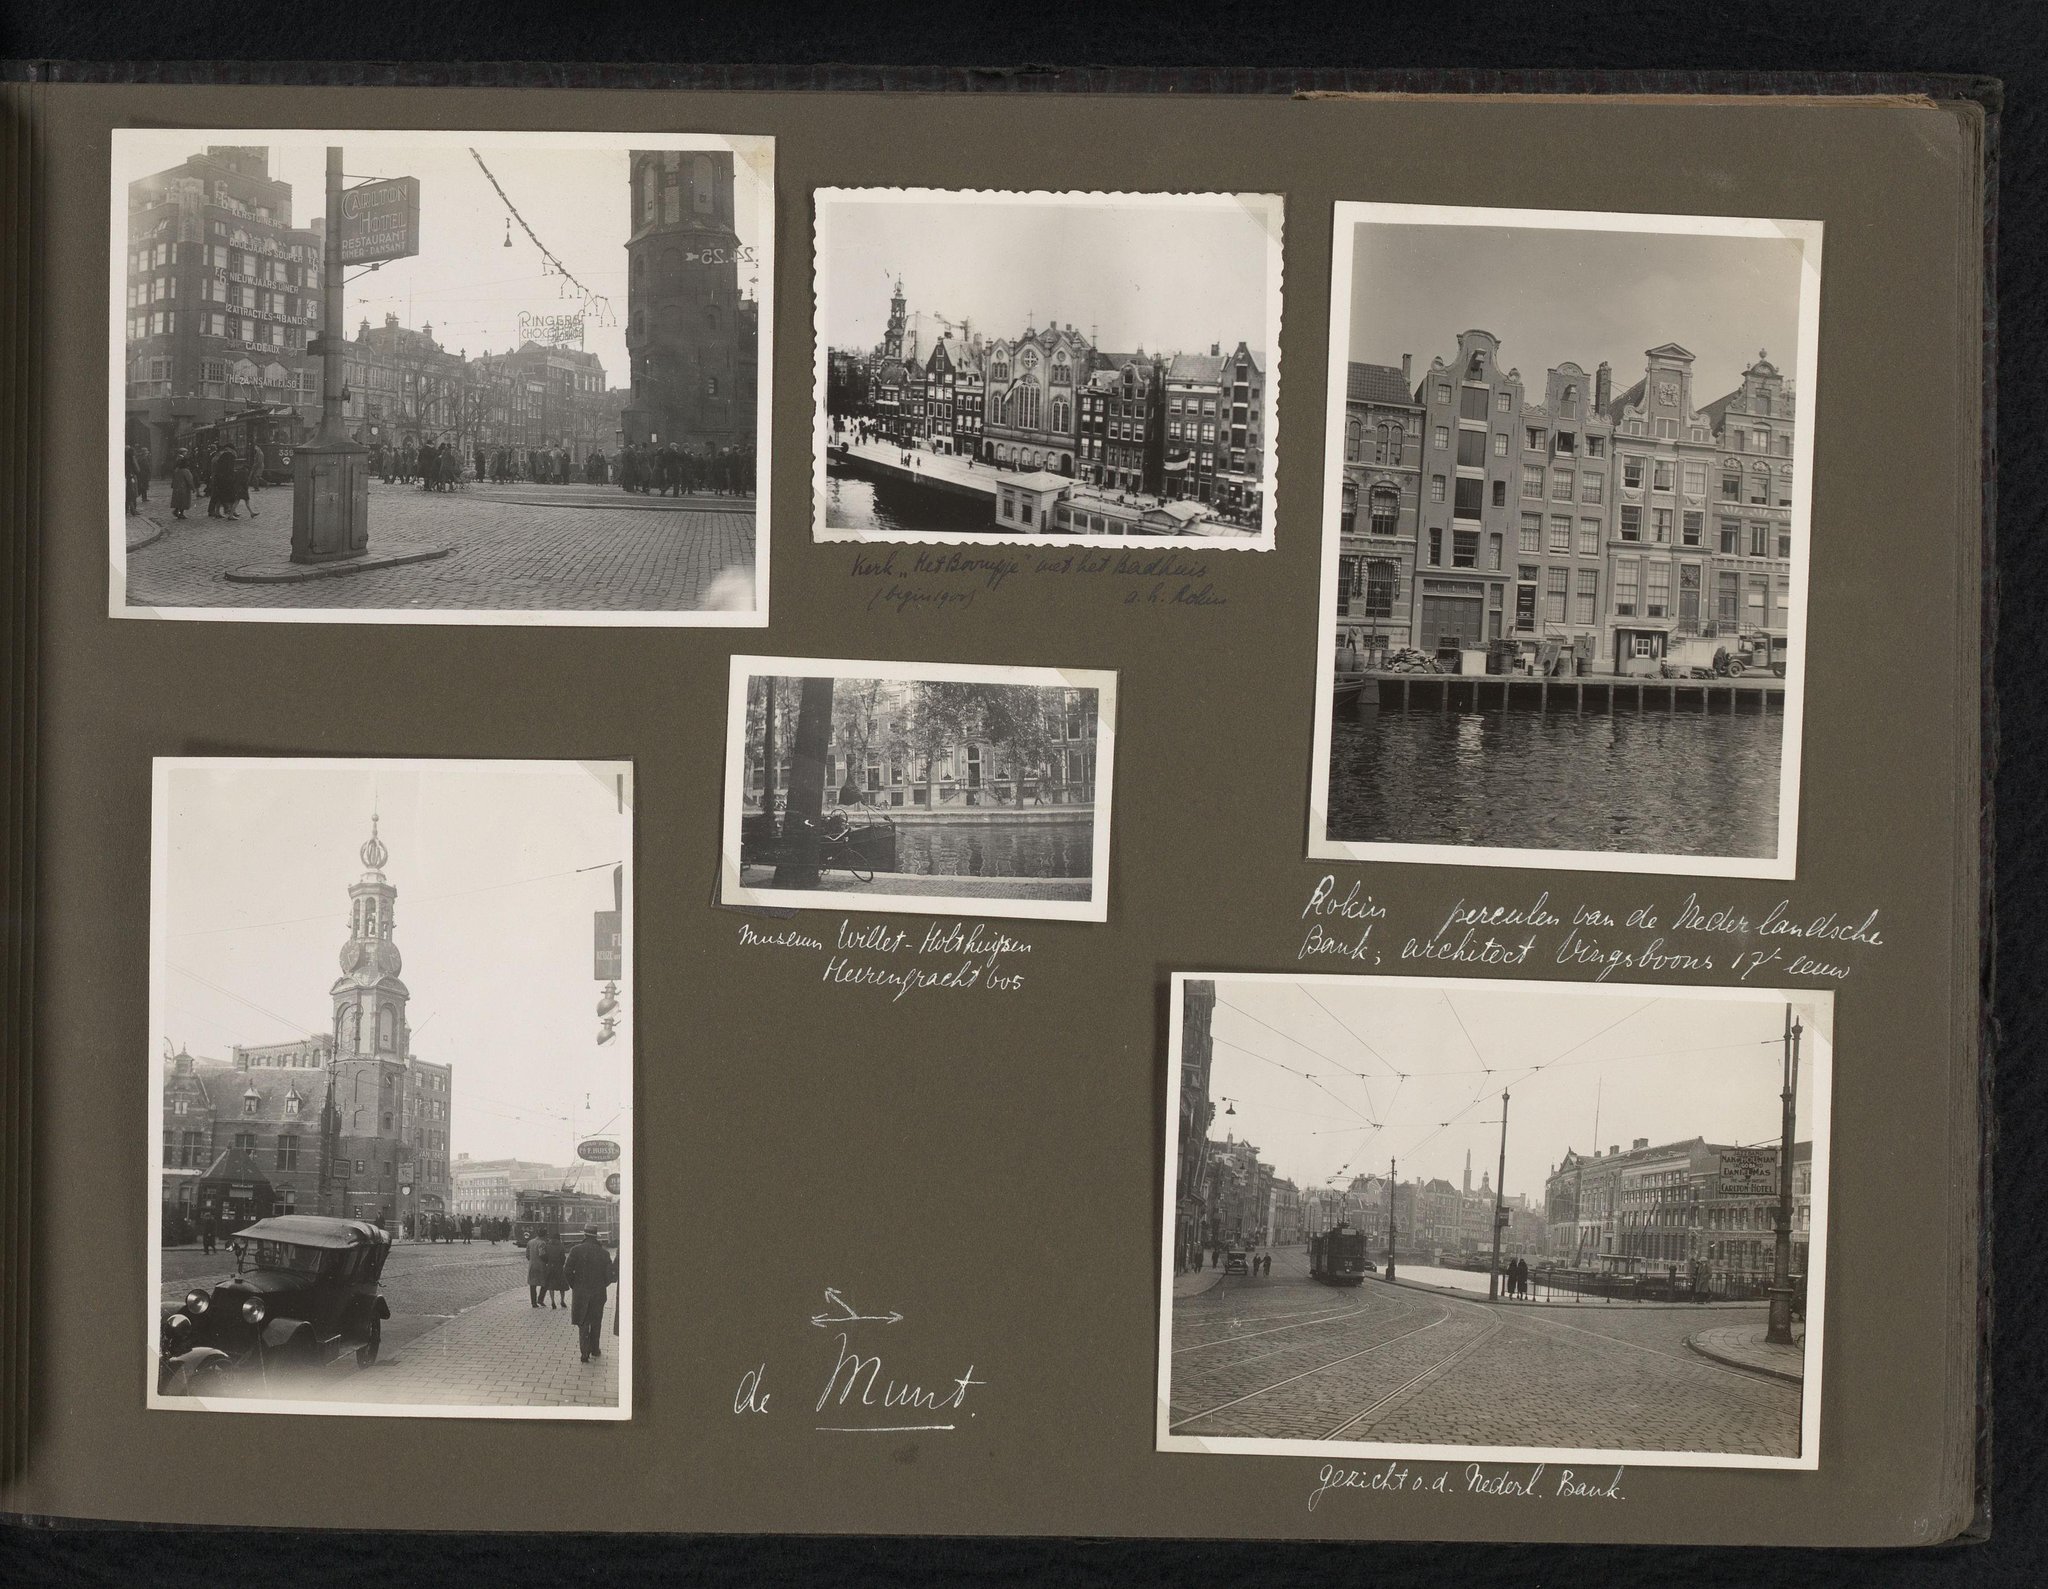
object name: reproduction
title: Amsterdam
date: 1930-1931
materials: paper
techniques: gelatin silver print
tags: urban housing, canals, waters (in city)